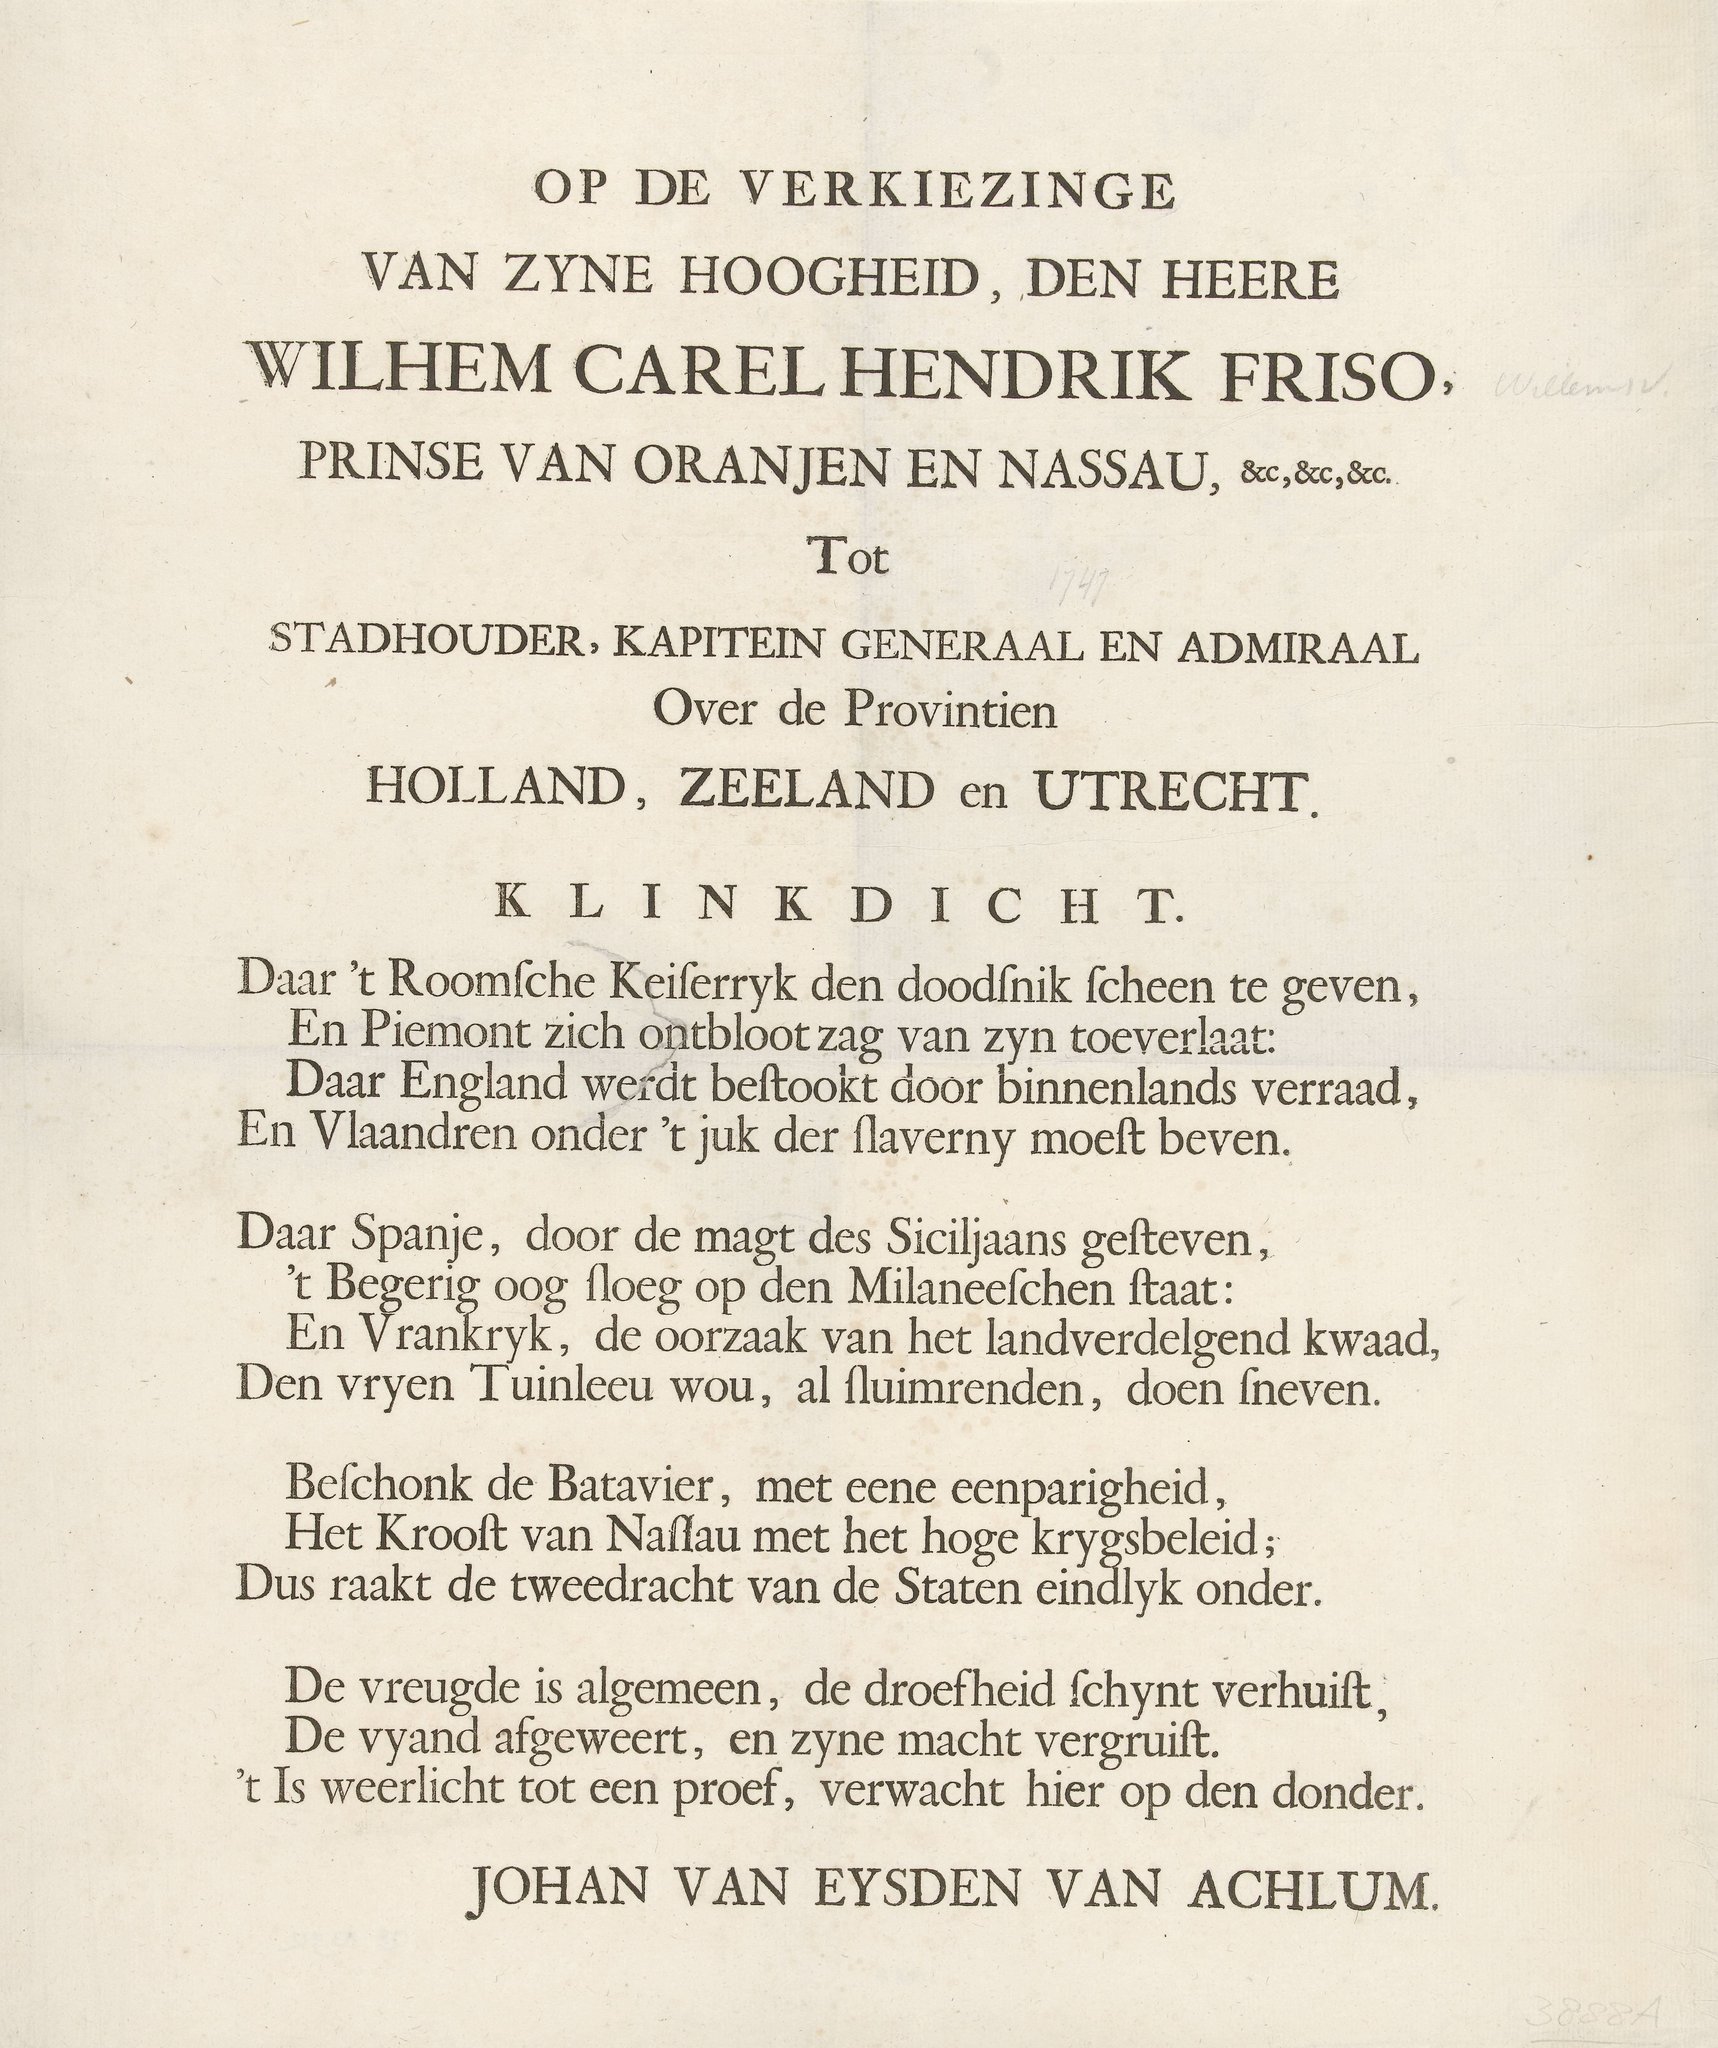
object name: poem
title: Op de verkiezinge van zyne hoogheid, den heere Wilhelm Carel Hendrik Friso, prinse van Oranjen en Nassau, &c, &c, &c. tot stadhouder, kapitein generaal en admiraal over de Provintien Holland, Zeeland en Utrecht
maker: johan van eysden van achlum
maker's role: schrijver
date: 1747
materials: paper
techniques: letterpress printing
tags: willem iv (prins van oranje-nassau)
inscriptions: collector's mark: Lugt 2228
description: Tekstblad met een klinkdicht van 14 regels op de verkiezing van Willem IV tot stadhouder, mei 1747.